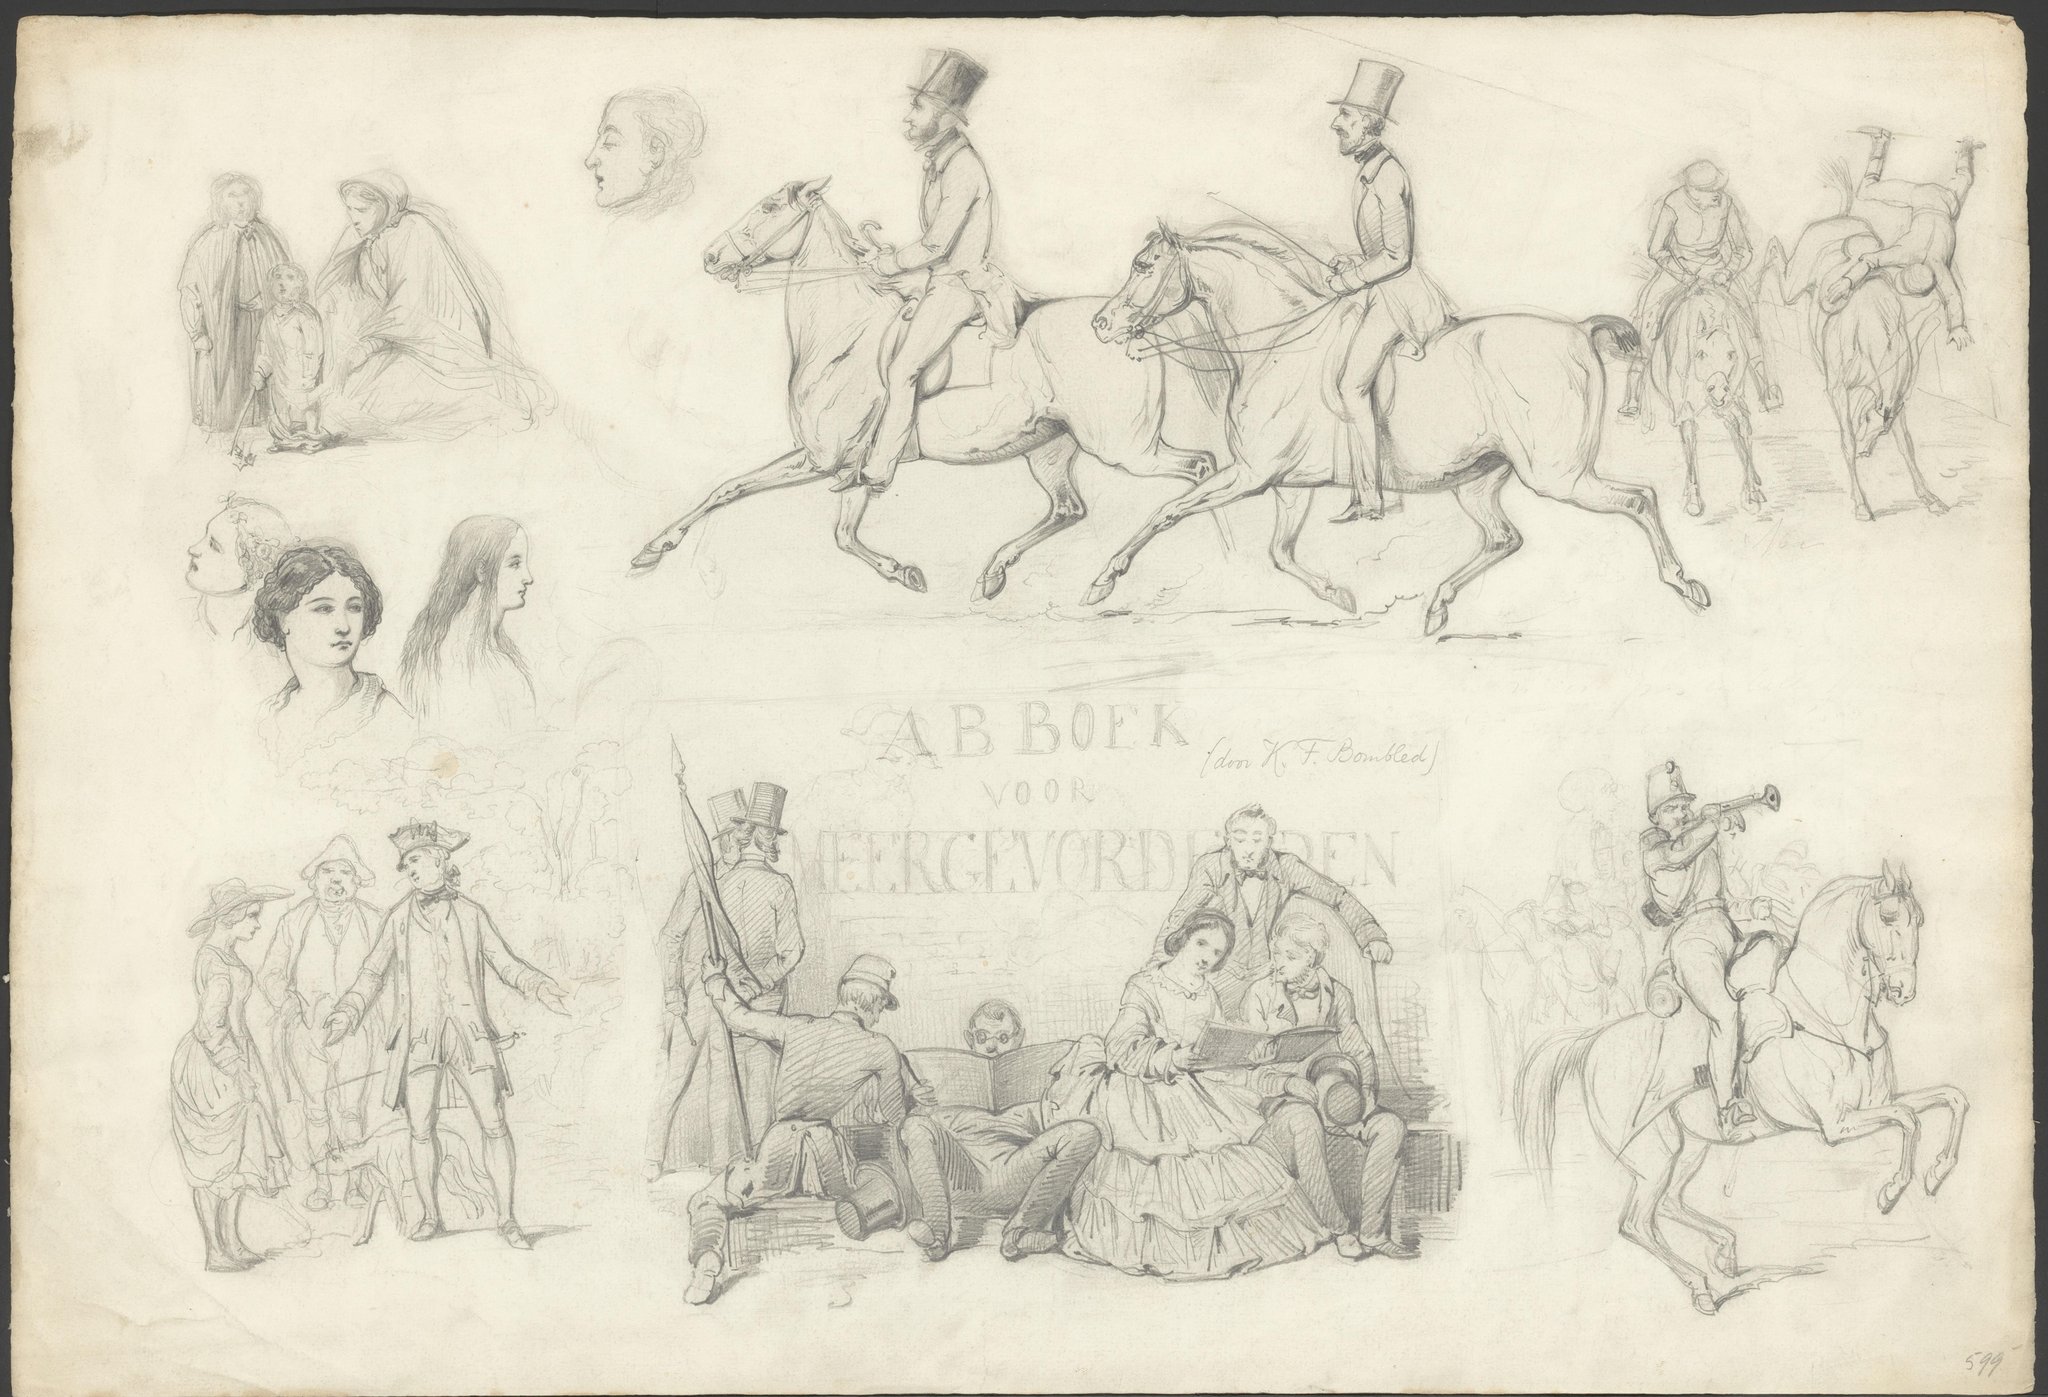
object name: drawing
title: AB Boek voor Veergevordeden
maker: karel frederik bombled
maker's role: draughtsman, print maker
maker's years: 1822-1902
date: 1864-1902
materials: paper, pencil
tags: horse throwing rider, face, reading, horse-racing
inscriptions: stamp, collector's mark: Lugt 1641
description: Schetsblad met uiteenlopende studies van mensen, zoals mannen die op paarden rijden, een man die van zijn paard wordt gegooid, een groep lezende mensen en een trompetblazer te paard. Onderwerpsrubrieken binnen de Atlas Zeden en Gewoonten: Schoone kunsten, Schilderkunst, Tekeningen.